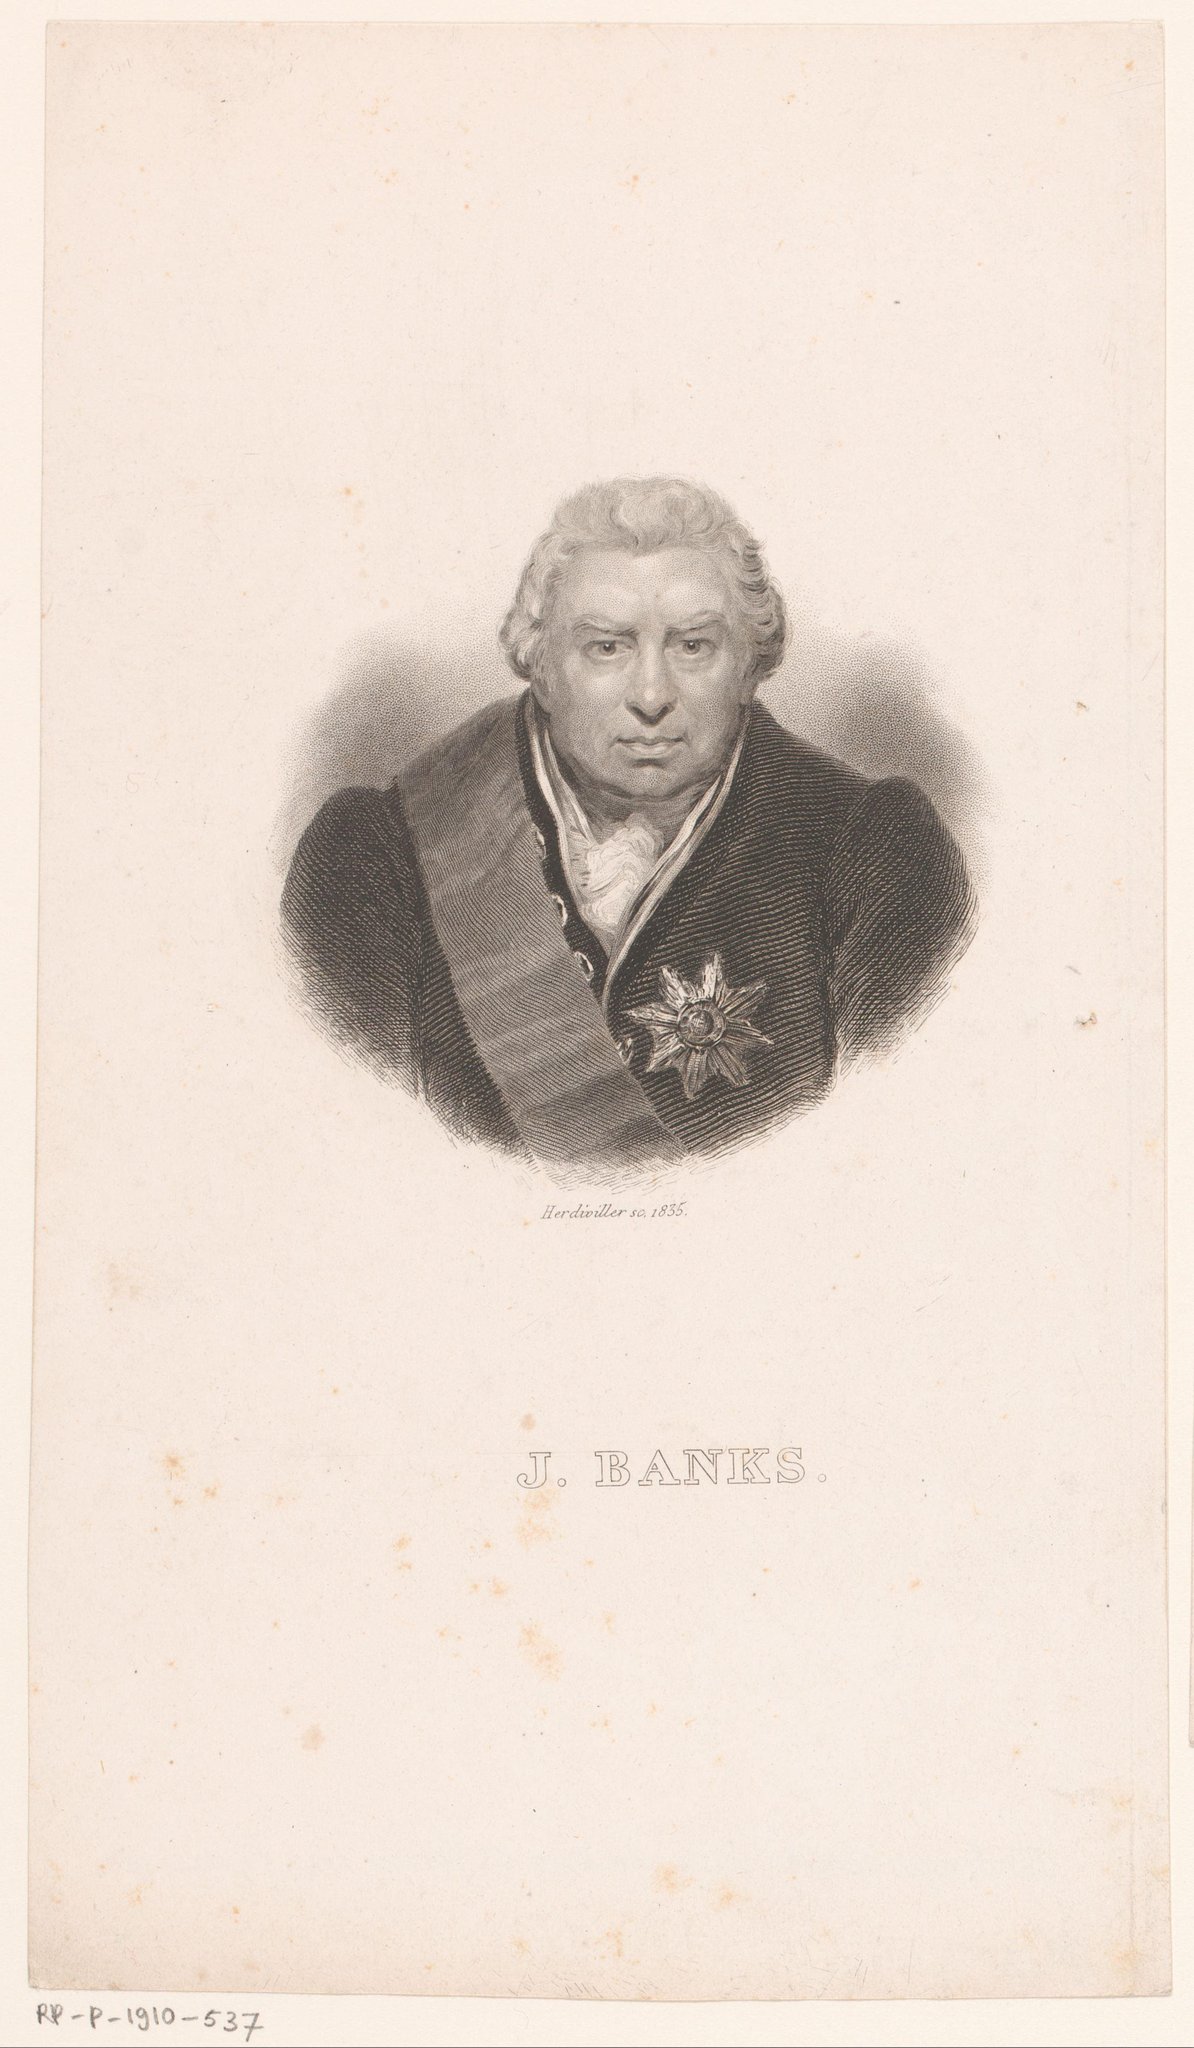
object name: print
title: Portret van Sir Joseph Banks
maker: charles achille d hardiviller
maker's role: print maker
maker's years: 1795-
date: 1835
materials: paper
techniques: etching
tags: london, joseph banks, scholar, philosopher, historical persons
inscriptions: collector's mark: Lugt 2228